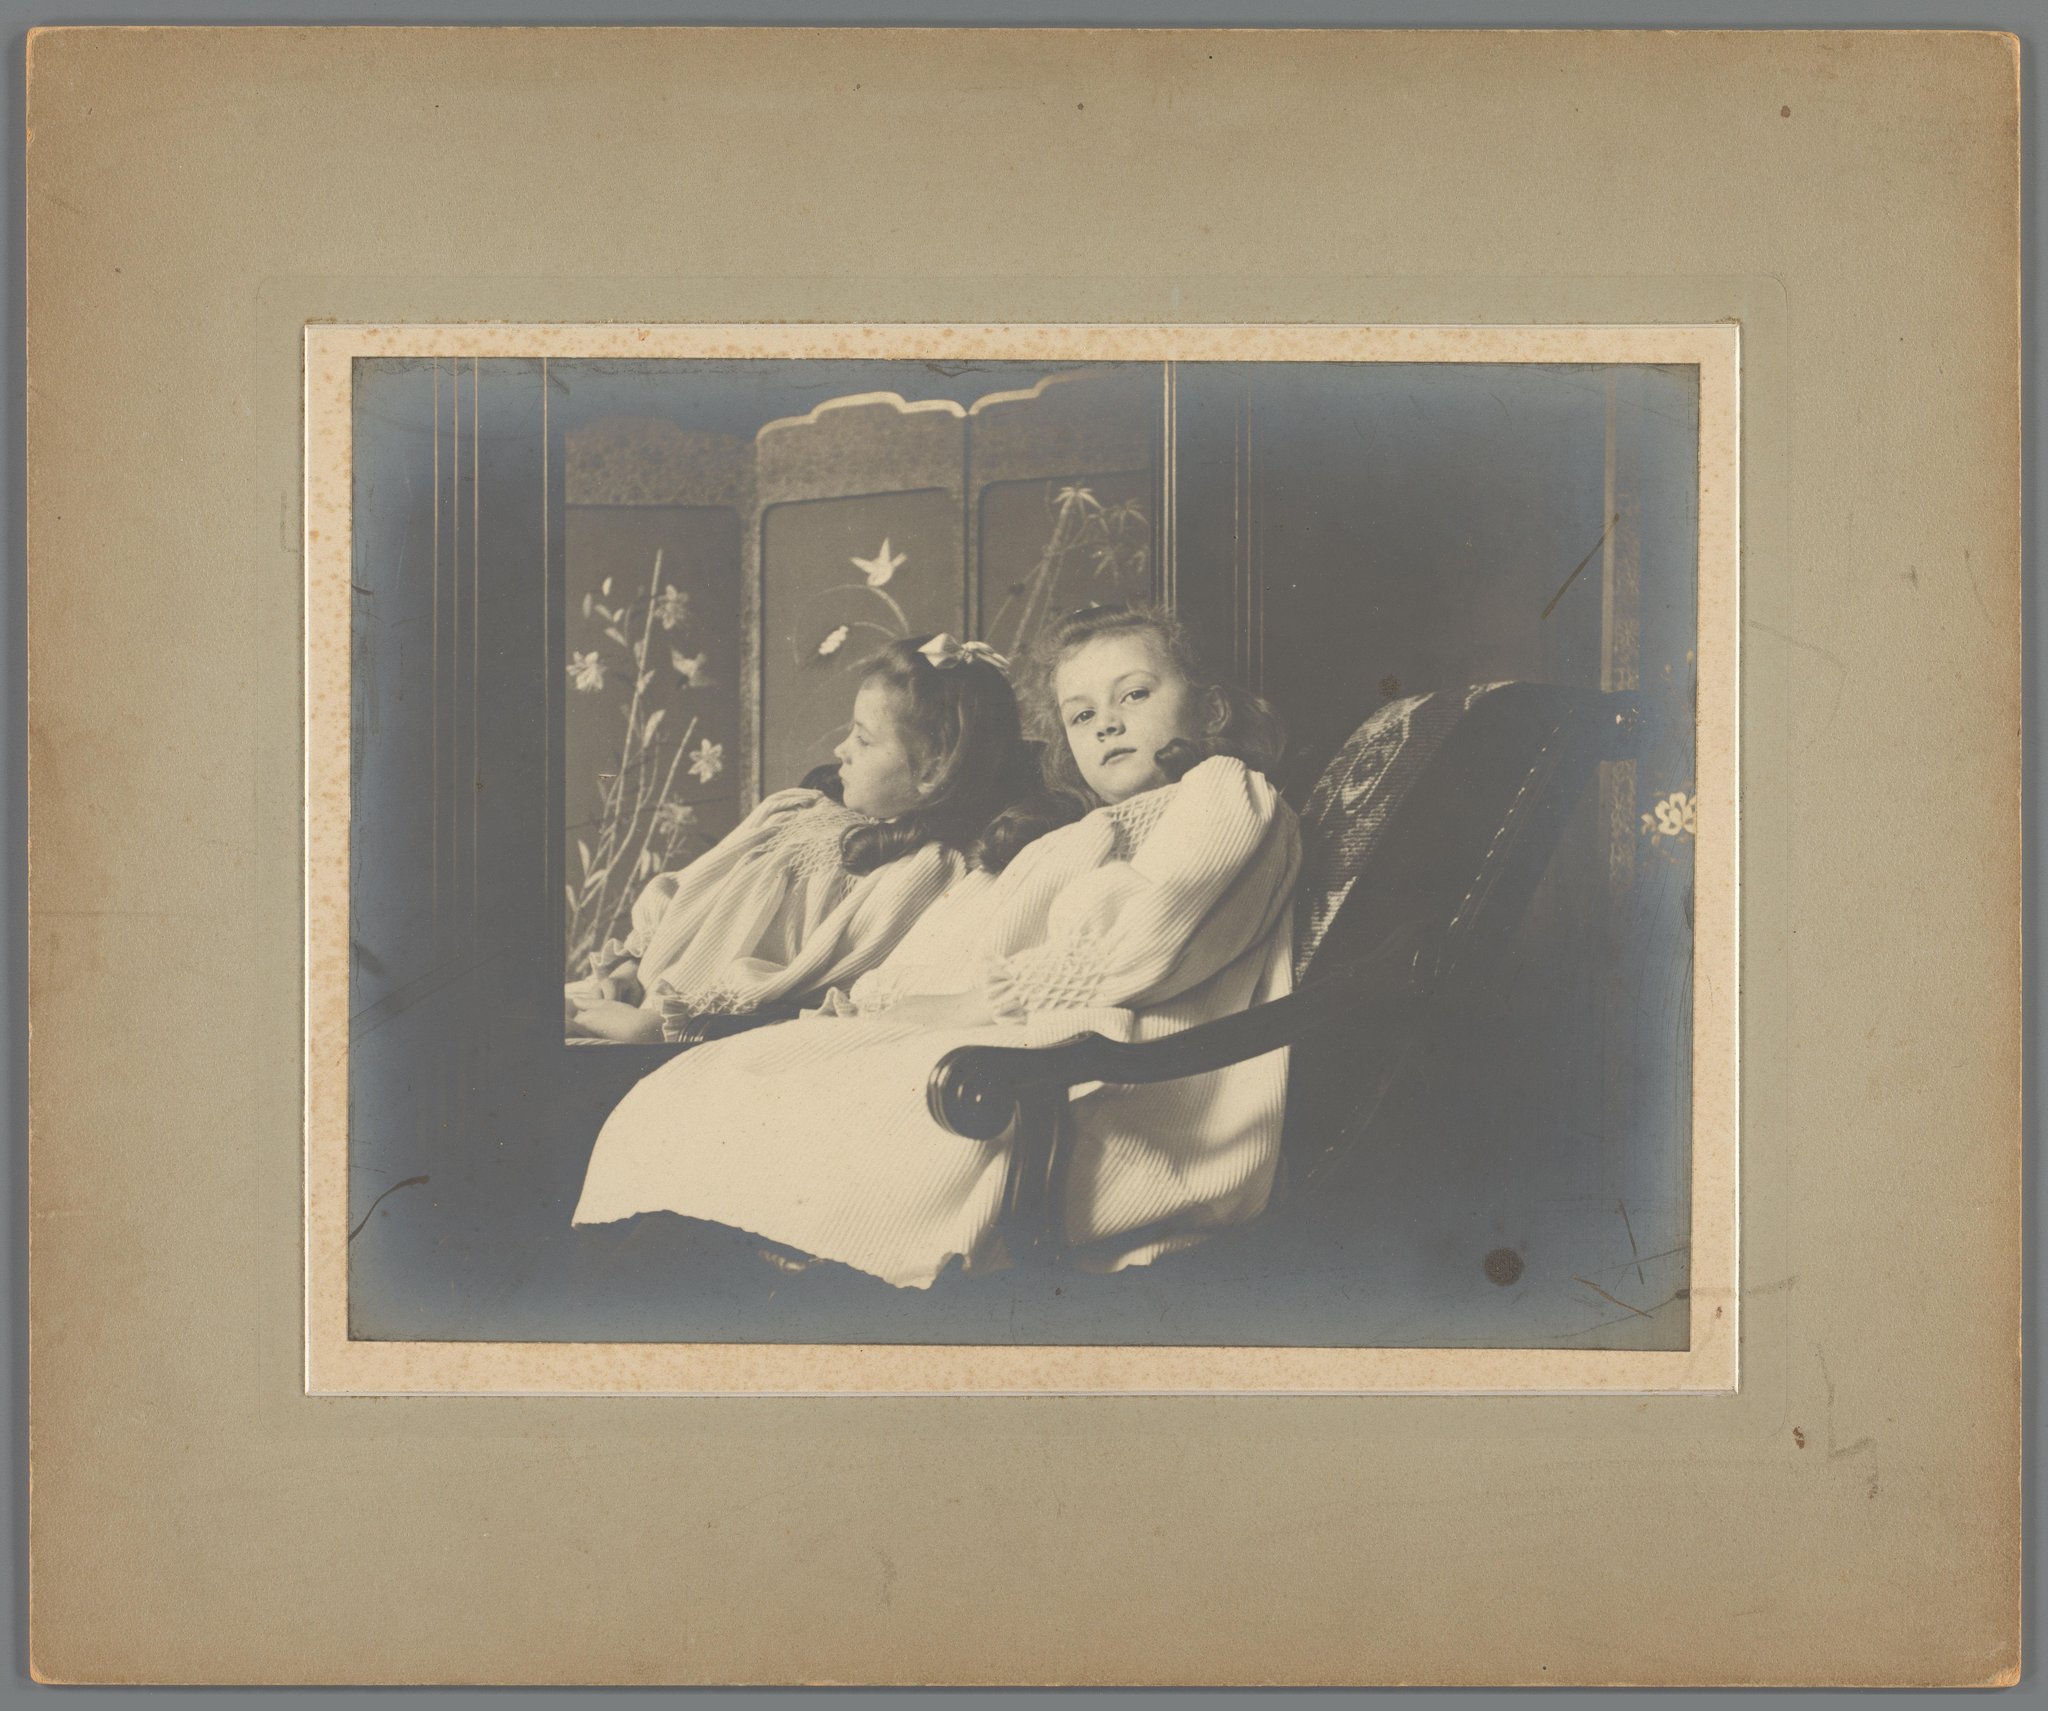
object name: photograph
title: Portret van Johanna (Hans) de Jong zittend voor een spiegel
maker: willem de jong (fotograaf)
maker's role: arts, fotograaf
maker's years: 1864-1918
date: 1900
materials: paper, cardboard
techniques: gelatin silver print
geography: leiden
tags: johanna petronella lambertina stokhuyzen-de jong (hans), historical persons, girl (child between toddler and youth), reflection (in a mirror) - aa - (for) women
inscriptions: inscription: ‘H’